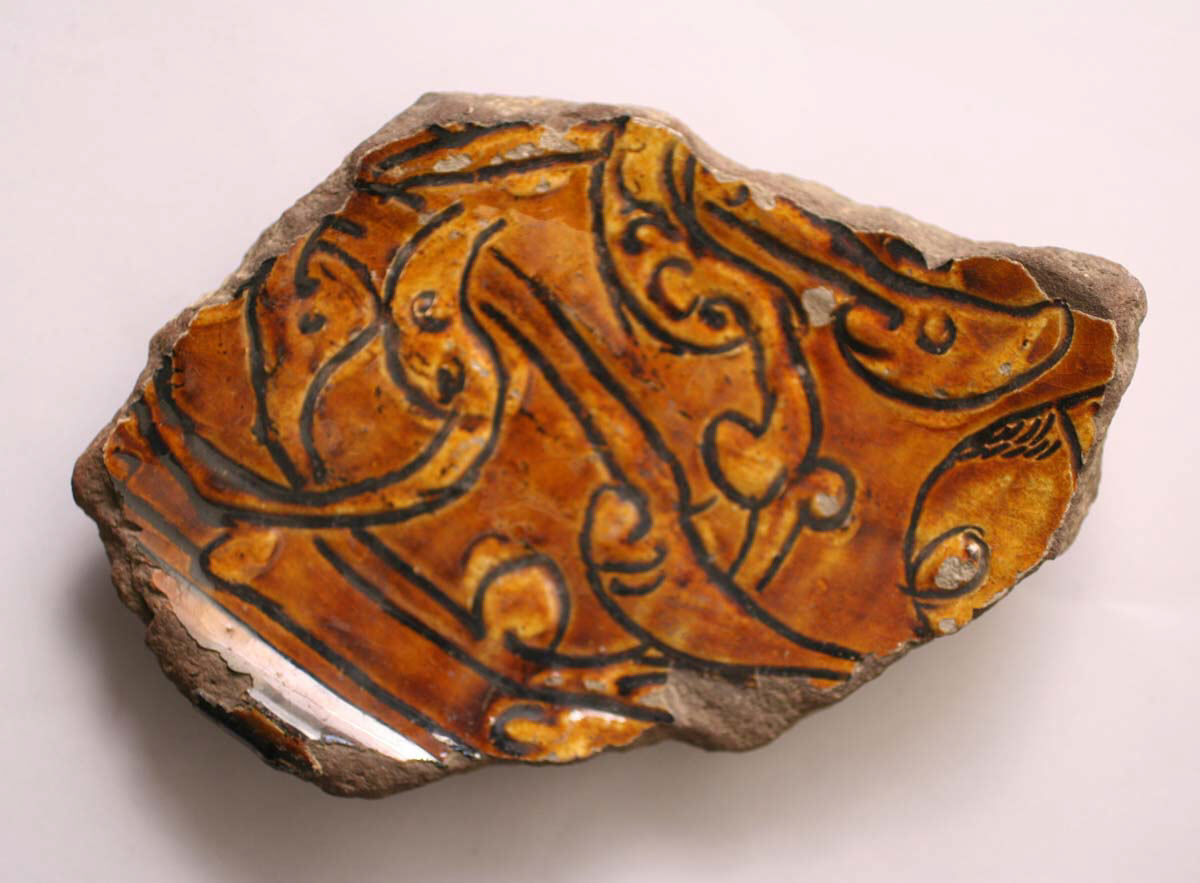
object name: fragment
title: Ceramic Fragment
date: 1301-1500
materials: earthenware, glaze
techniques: coloring, incising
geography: egypt